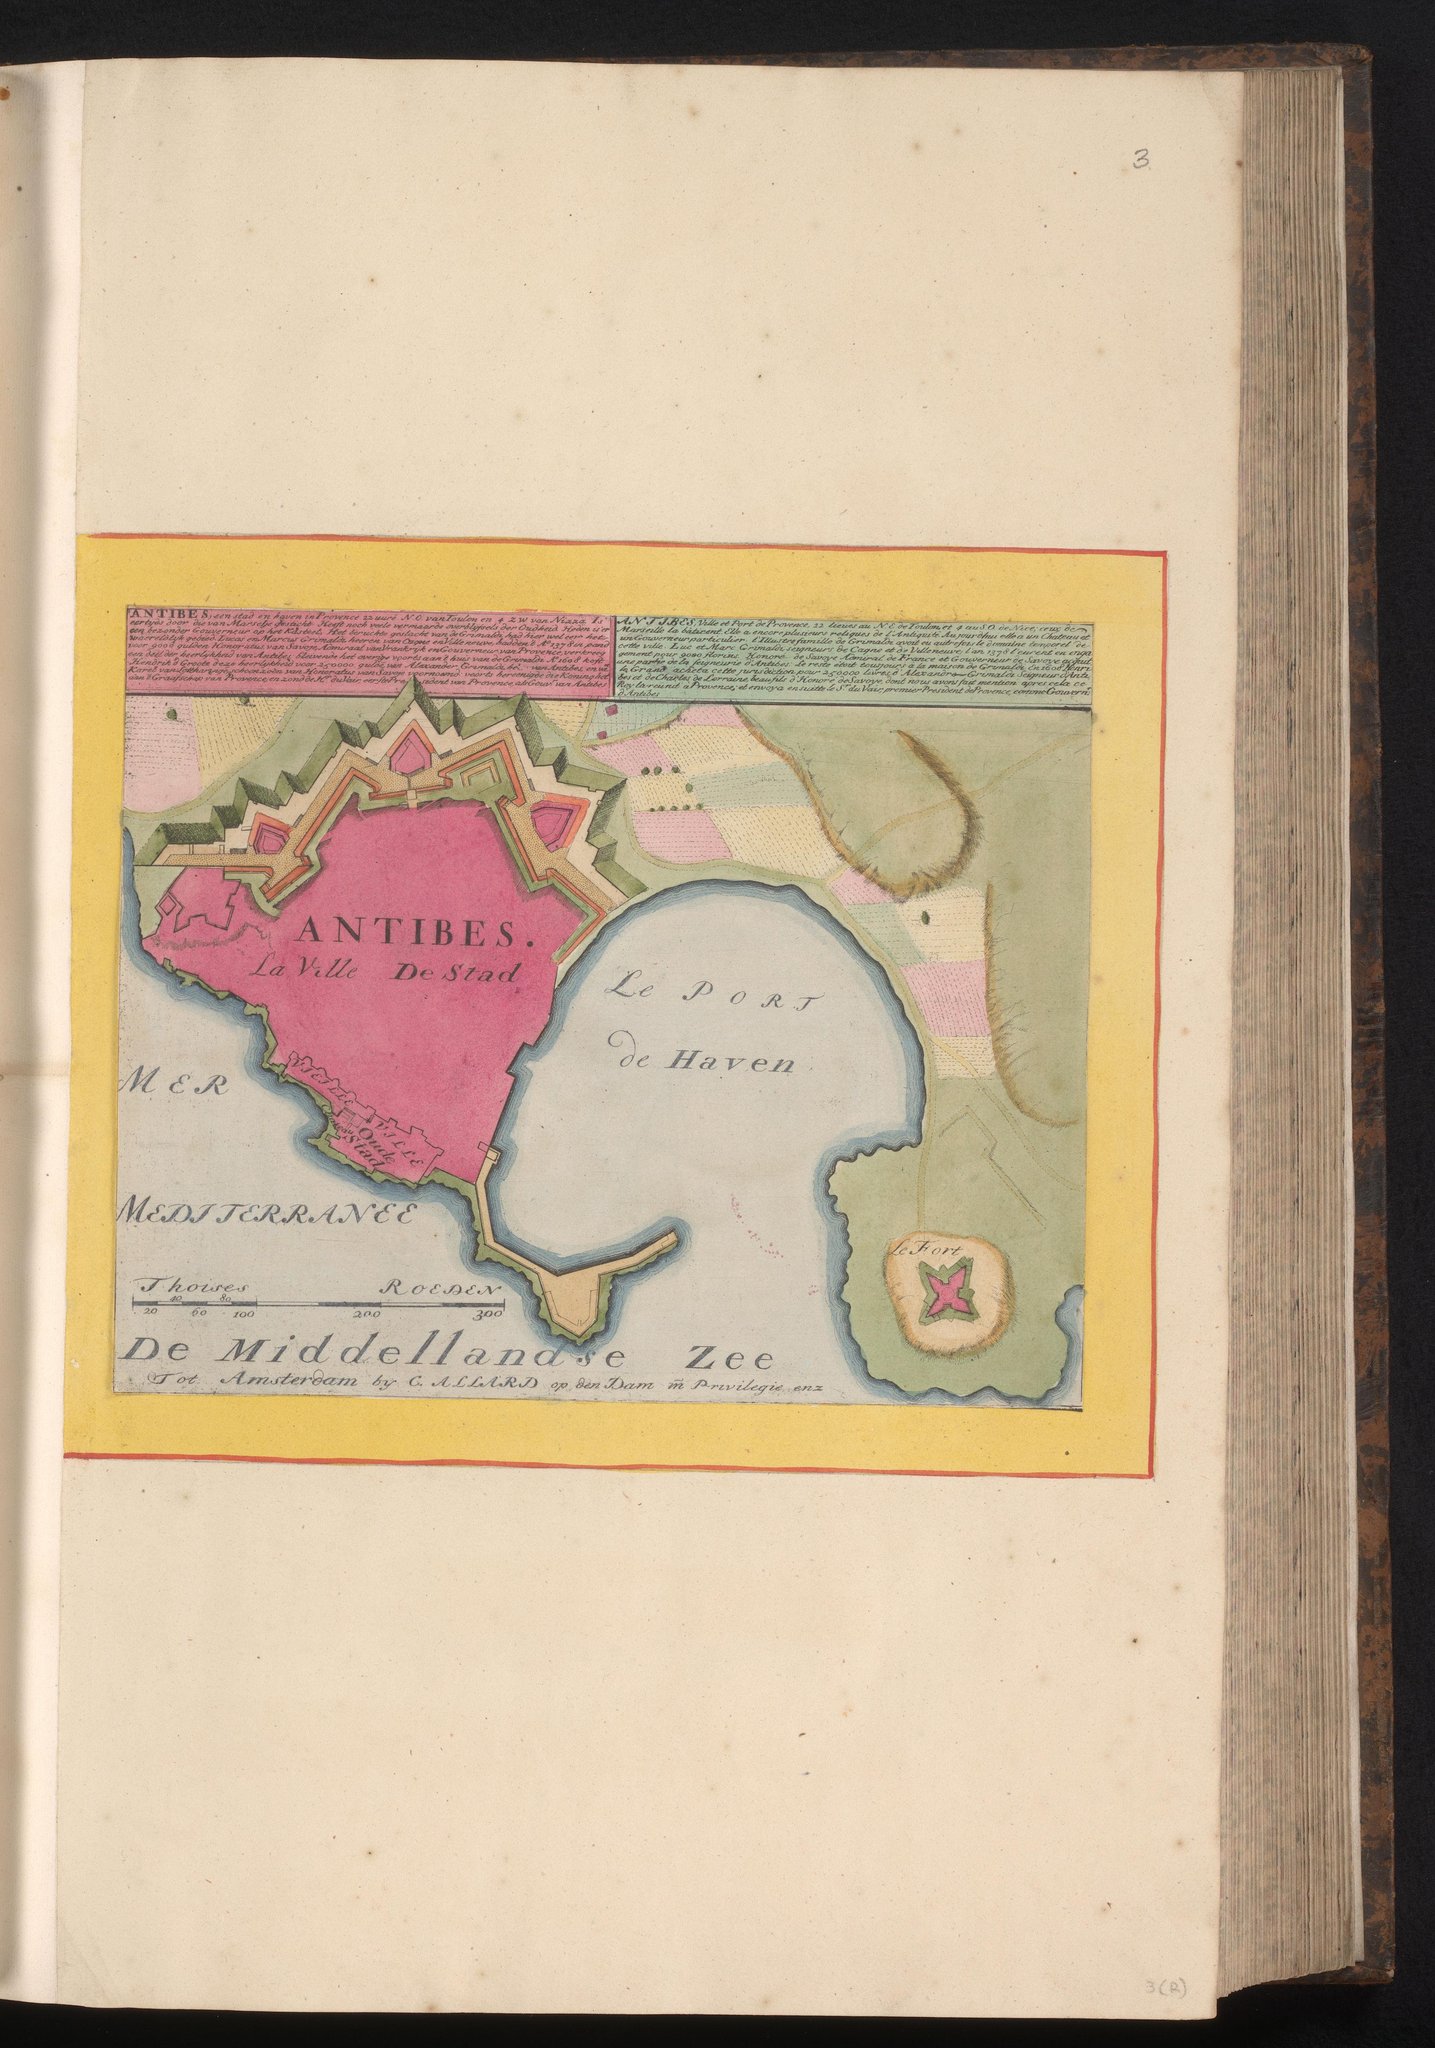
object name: album leaf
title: Vestingplattegrond van Antibes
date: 1658-1709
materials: paper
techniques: engraving, etching, hand coloring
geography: the hague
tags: maps of cities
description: Deze prent maakt deel uit van een album.